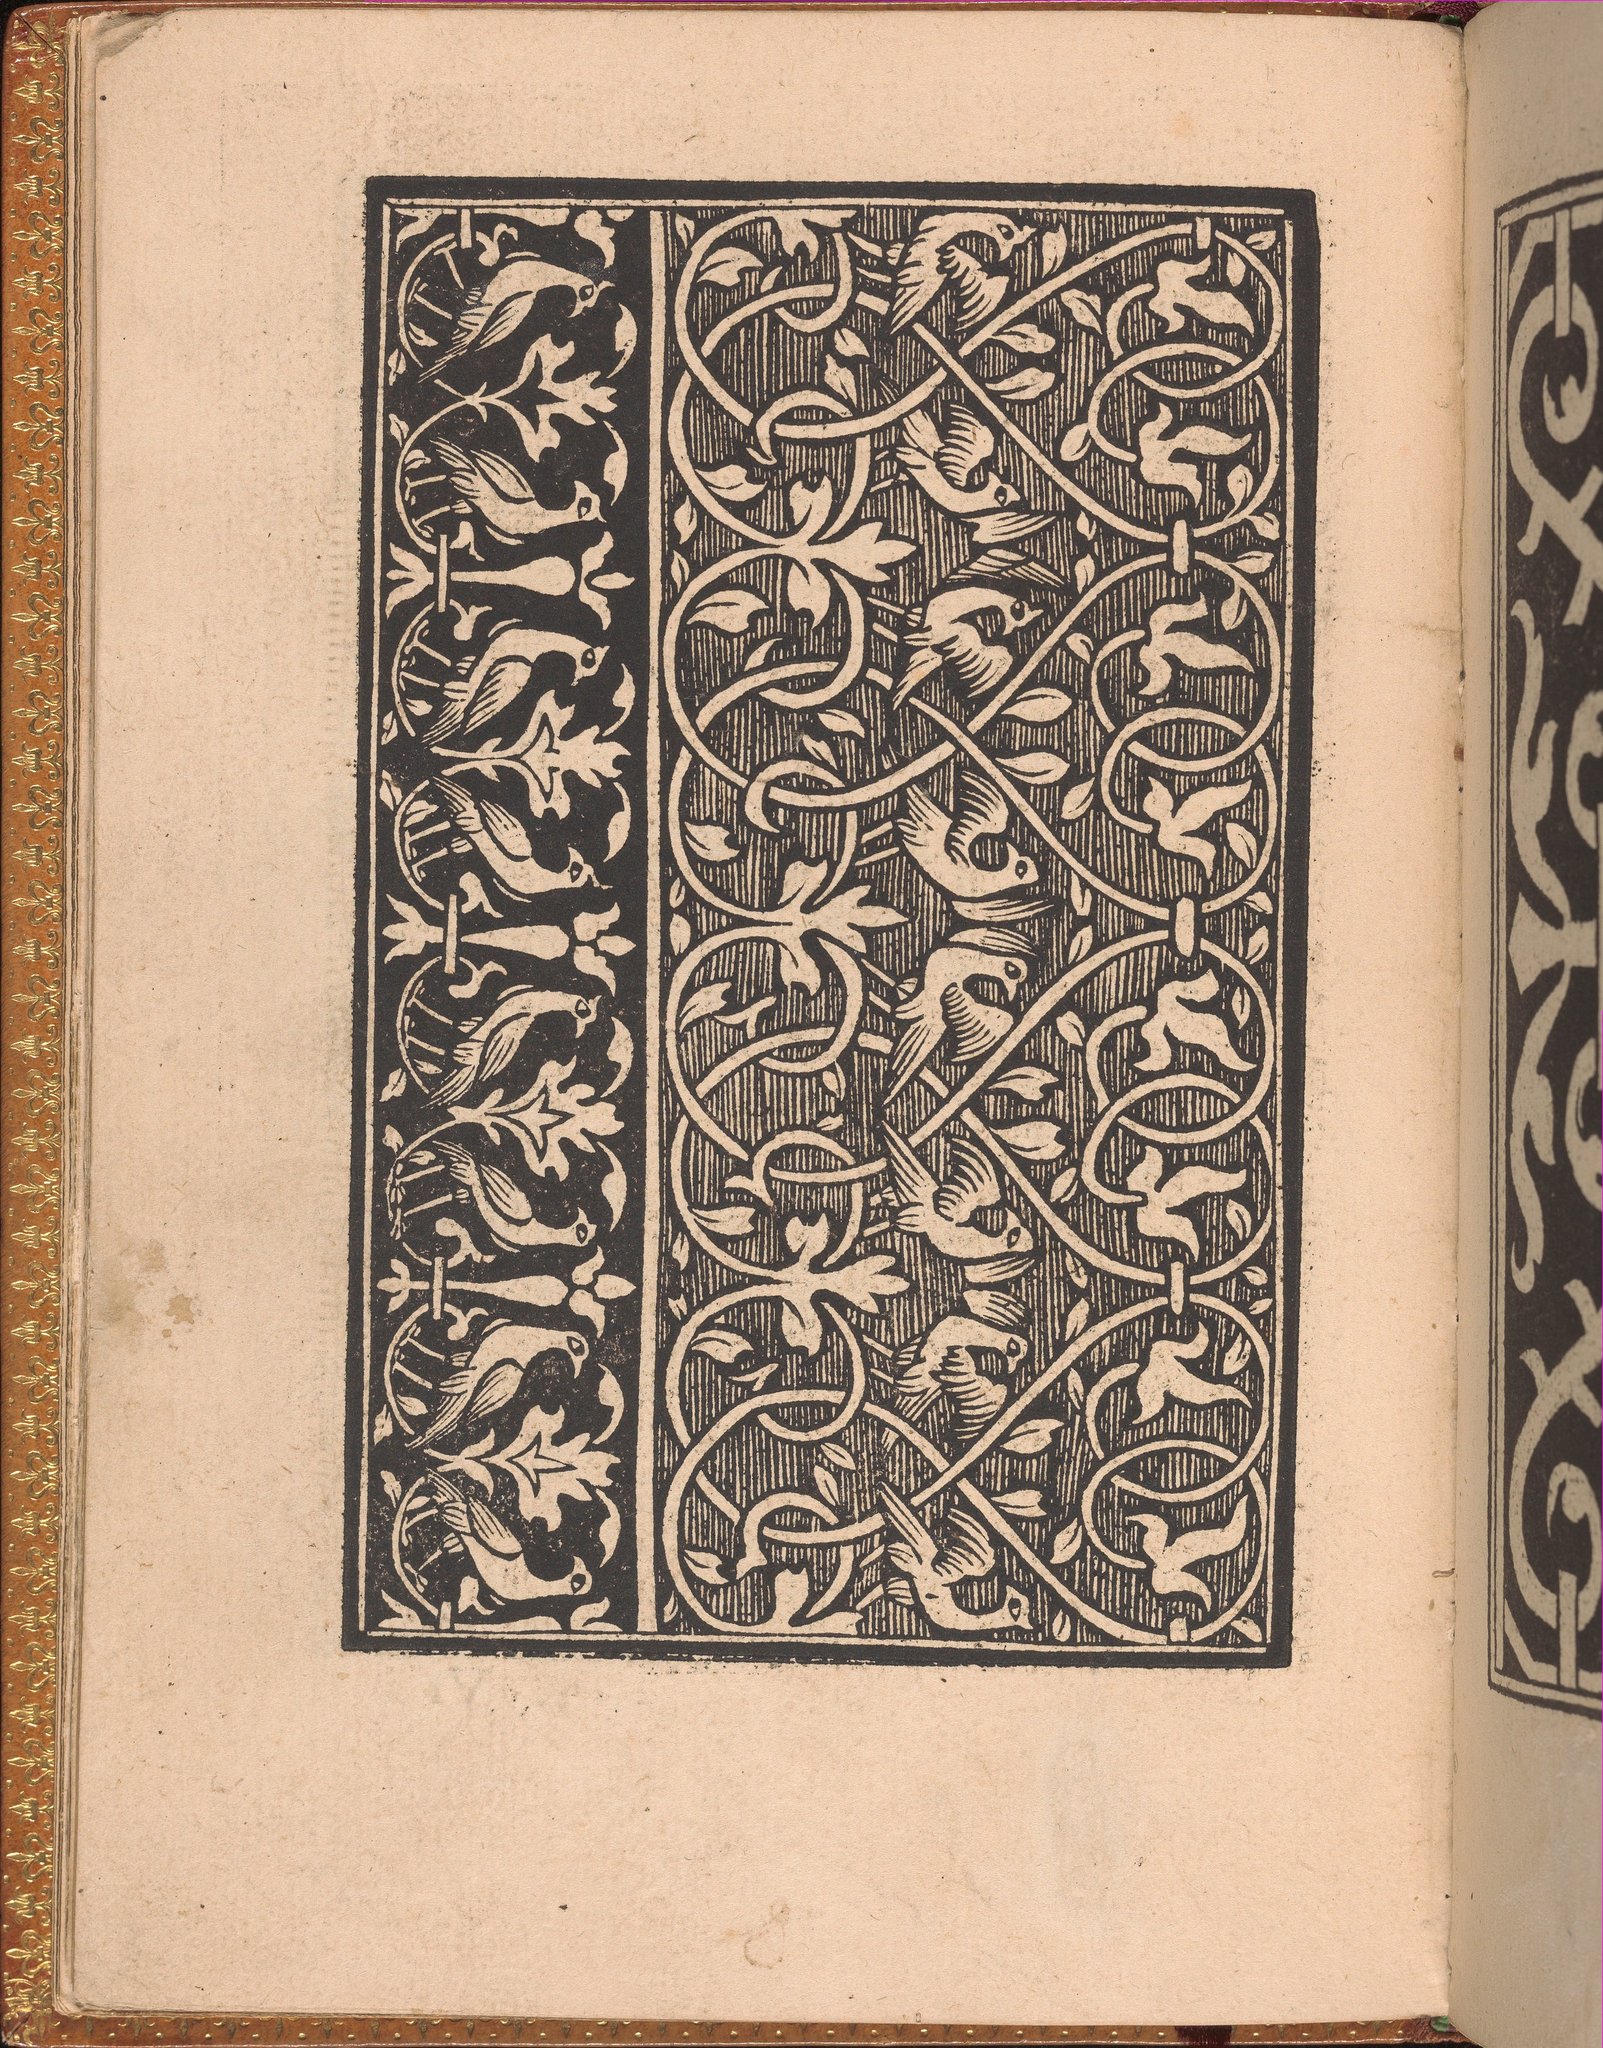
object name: book print ornament architecture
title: Convivio delle Belle Donne, page 7 (verso)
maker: nicolò zoppino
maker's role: publisher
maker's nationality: italian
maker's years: 1478-1544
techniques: woodcut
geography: italy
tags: birds